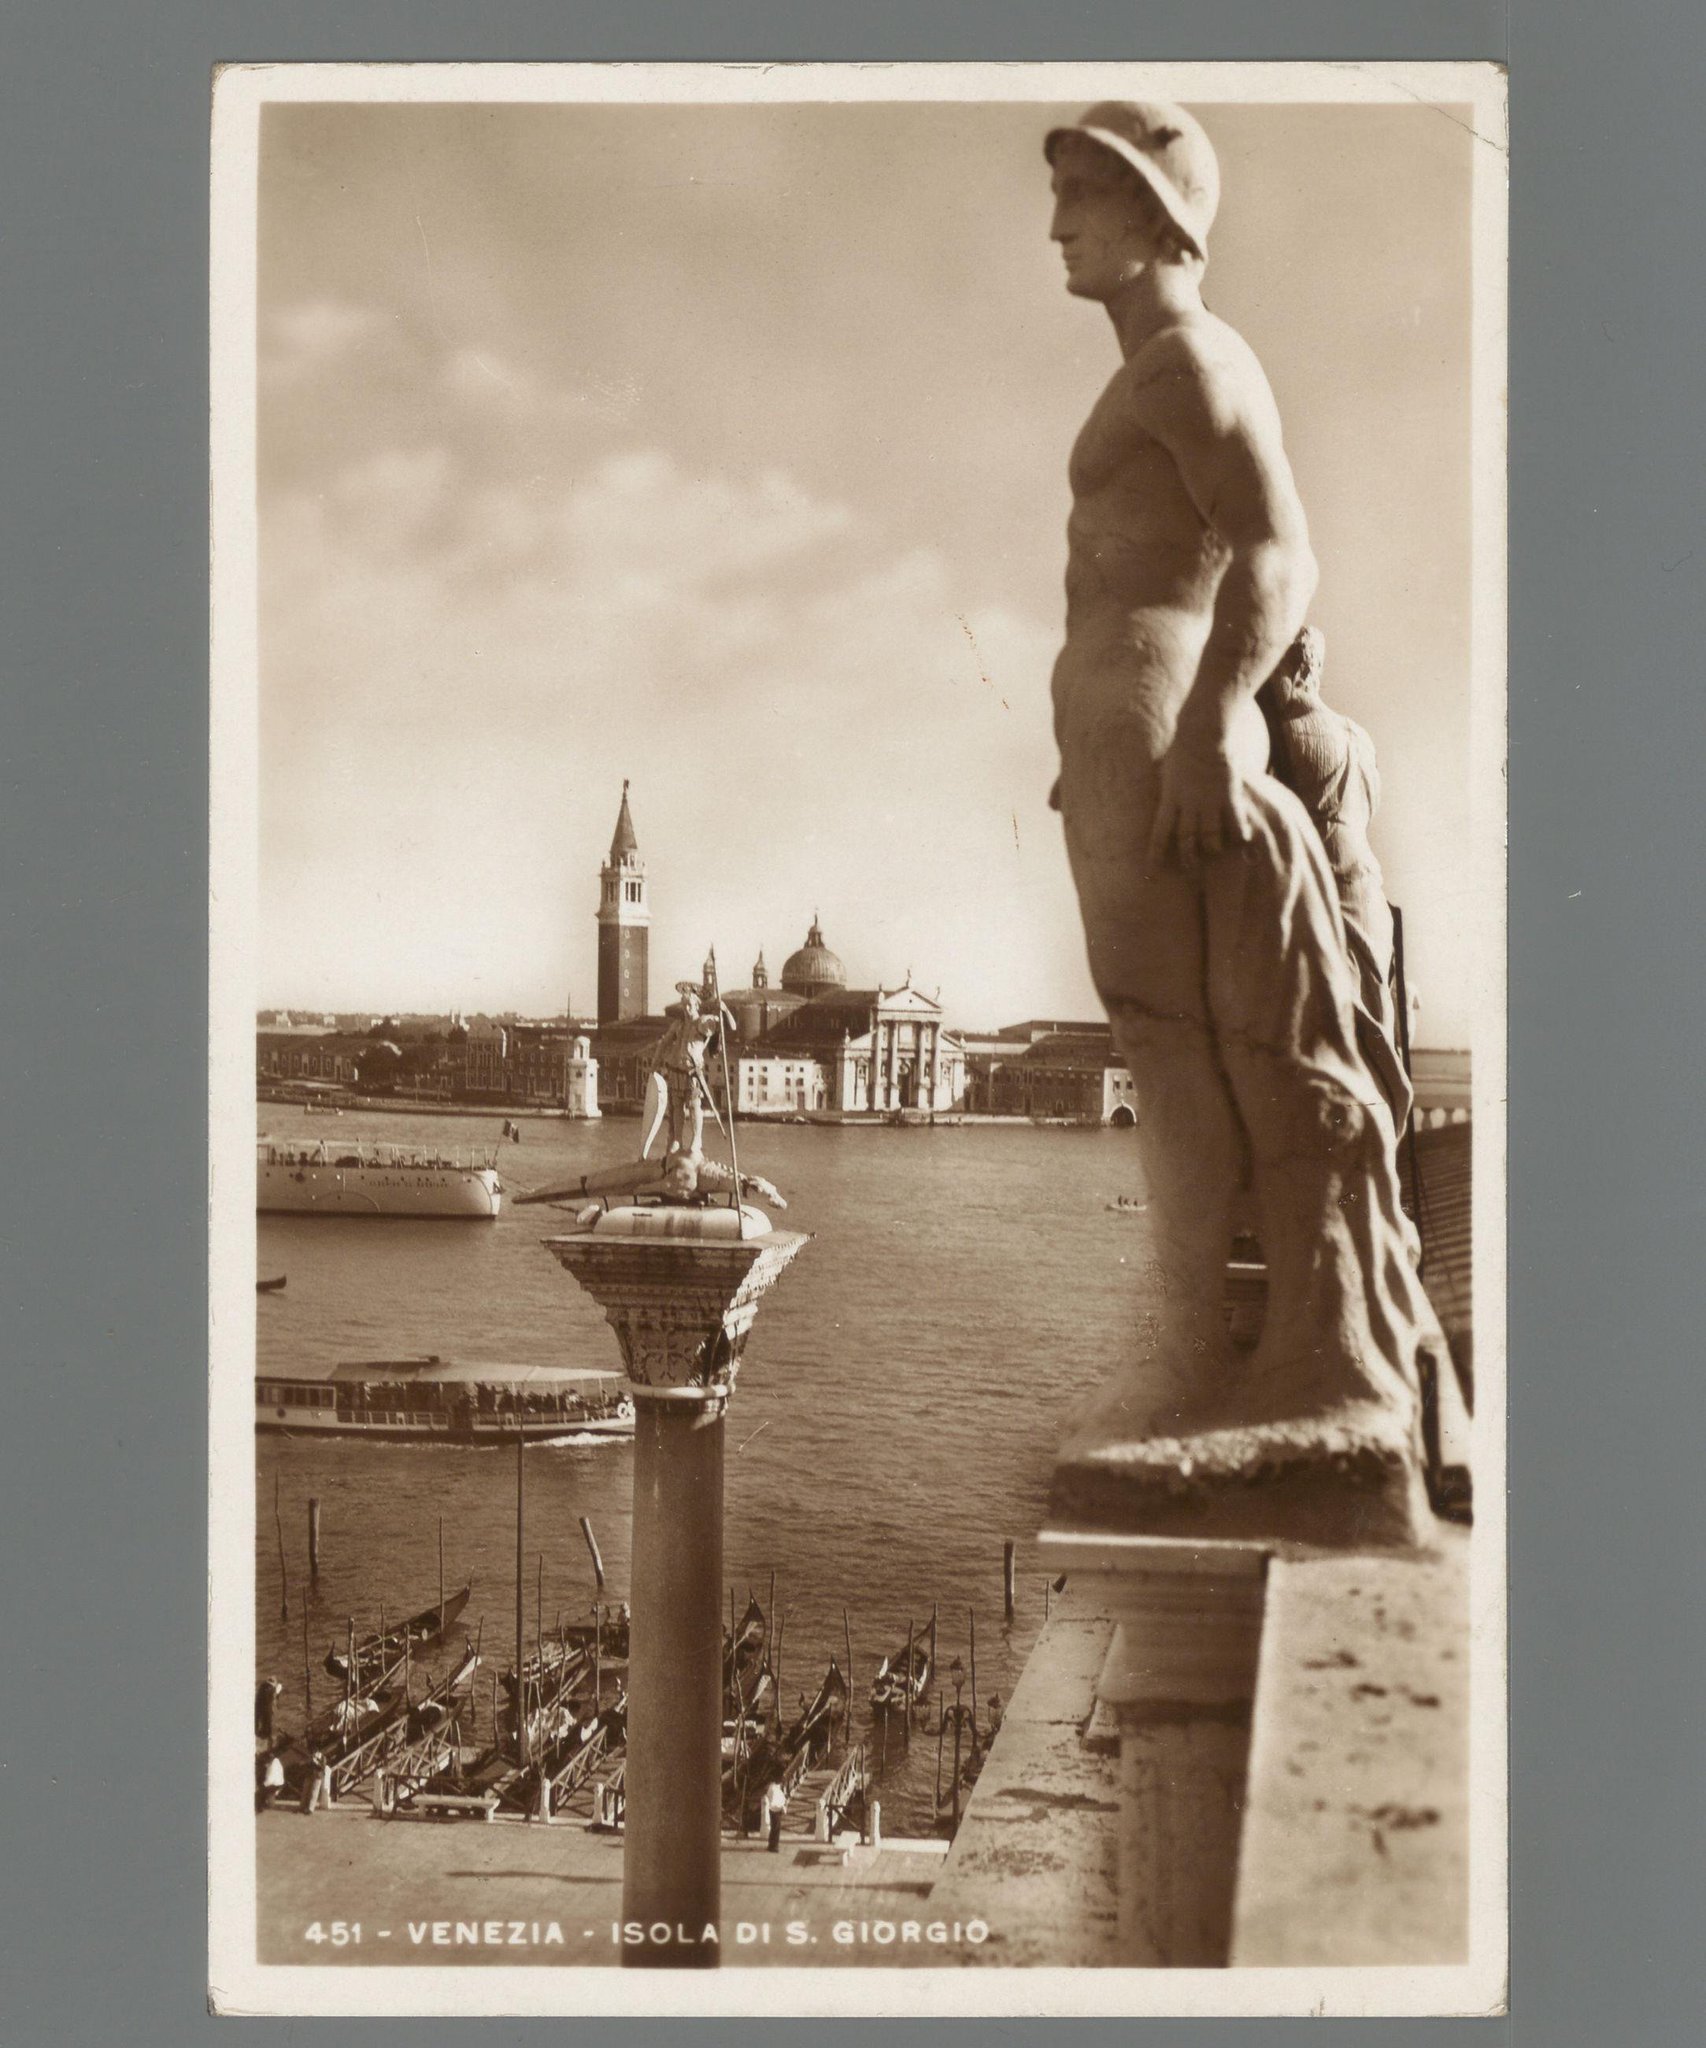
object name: photograph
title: Venezia. Isola di S. Giorgio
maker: Anonymous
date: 1935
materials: photographic support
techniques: photography, writing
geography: venice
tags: sculpture, gondola, city-view, and landscape with man-made constructions (+ city(-scape) with figures, staffage)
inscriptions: postage stamp